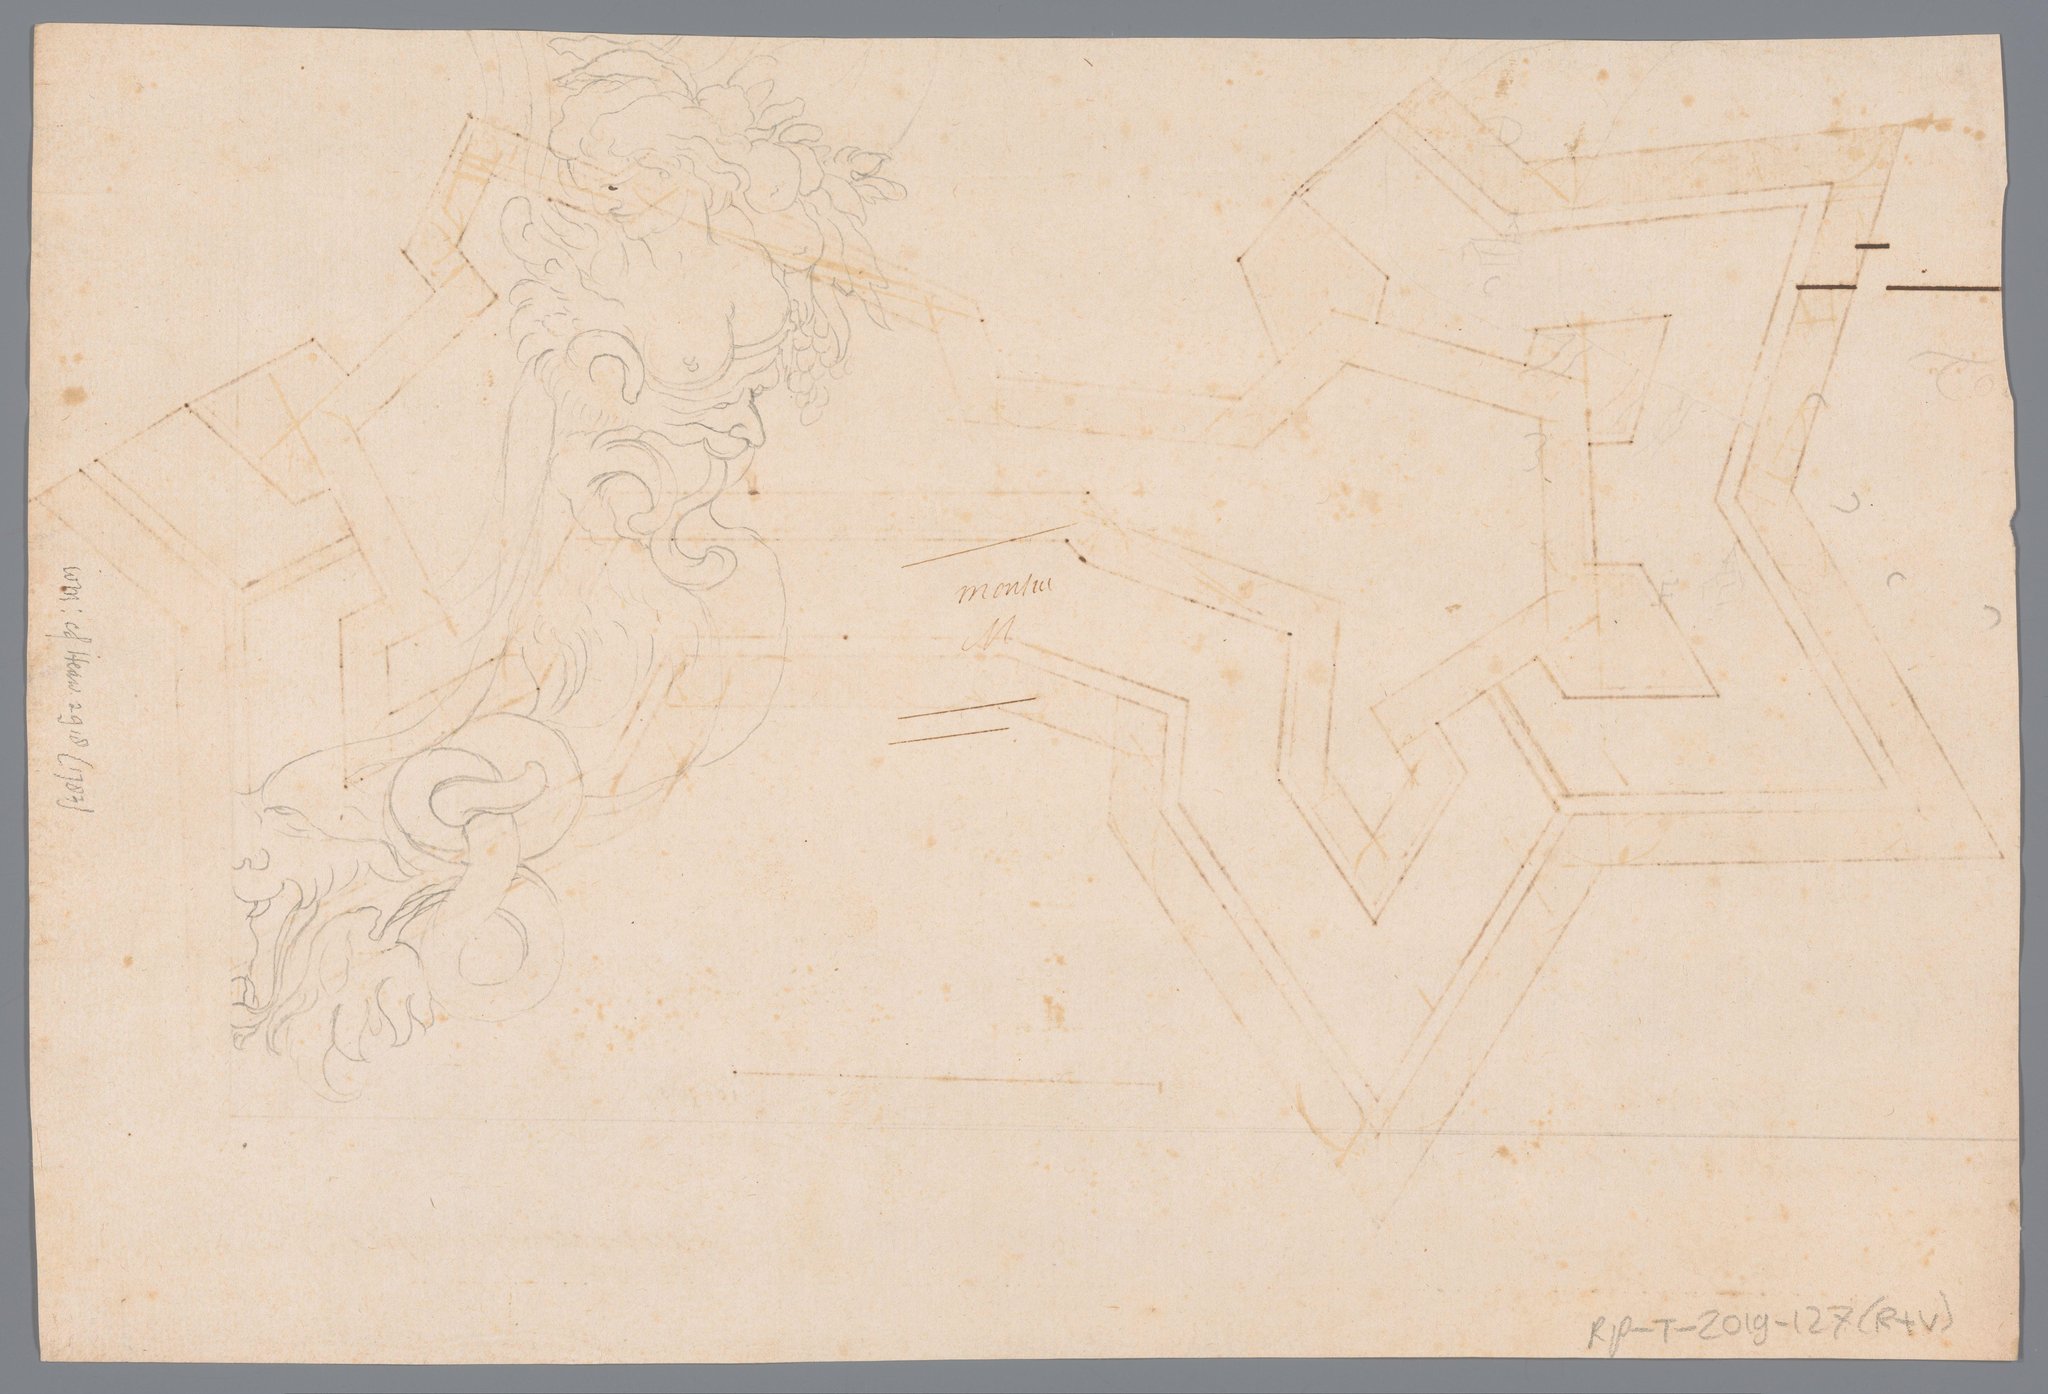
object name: drawing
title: Vrouwelijk fantasiefiguur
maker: Anonymous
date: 1783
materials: paper, pencil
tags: monsters ~ snakes - aa - female human figure (+ body)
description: Schets van een vrouwelijk figuur met slangenlichaam en fruit in het haar.